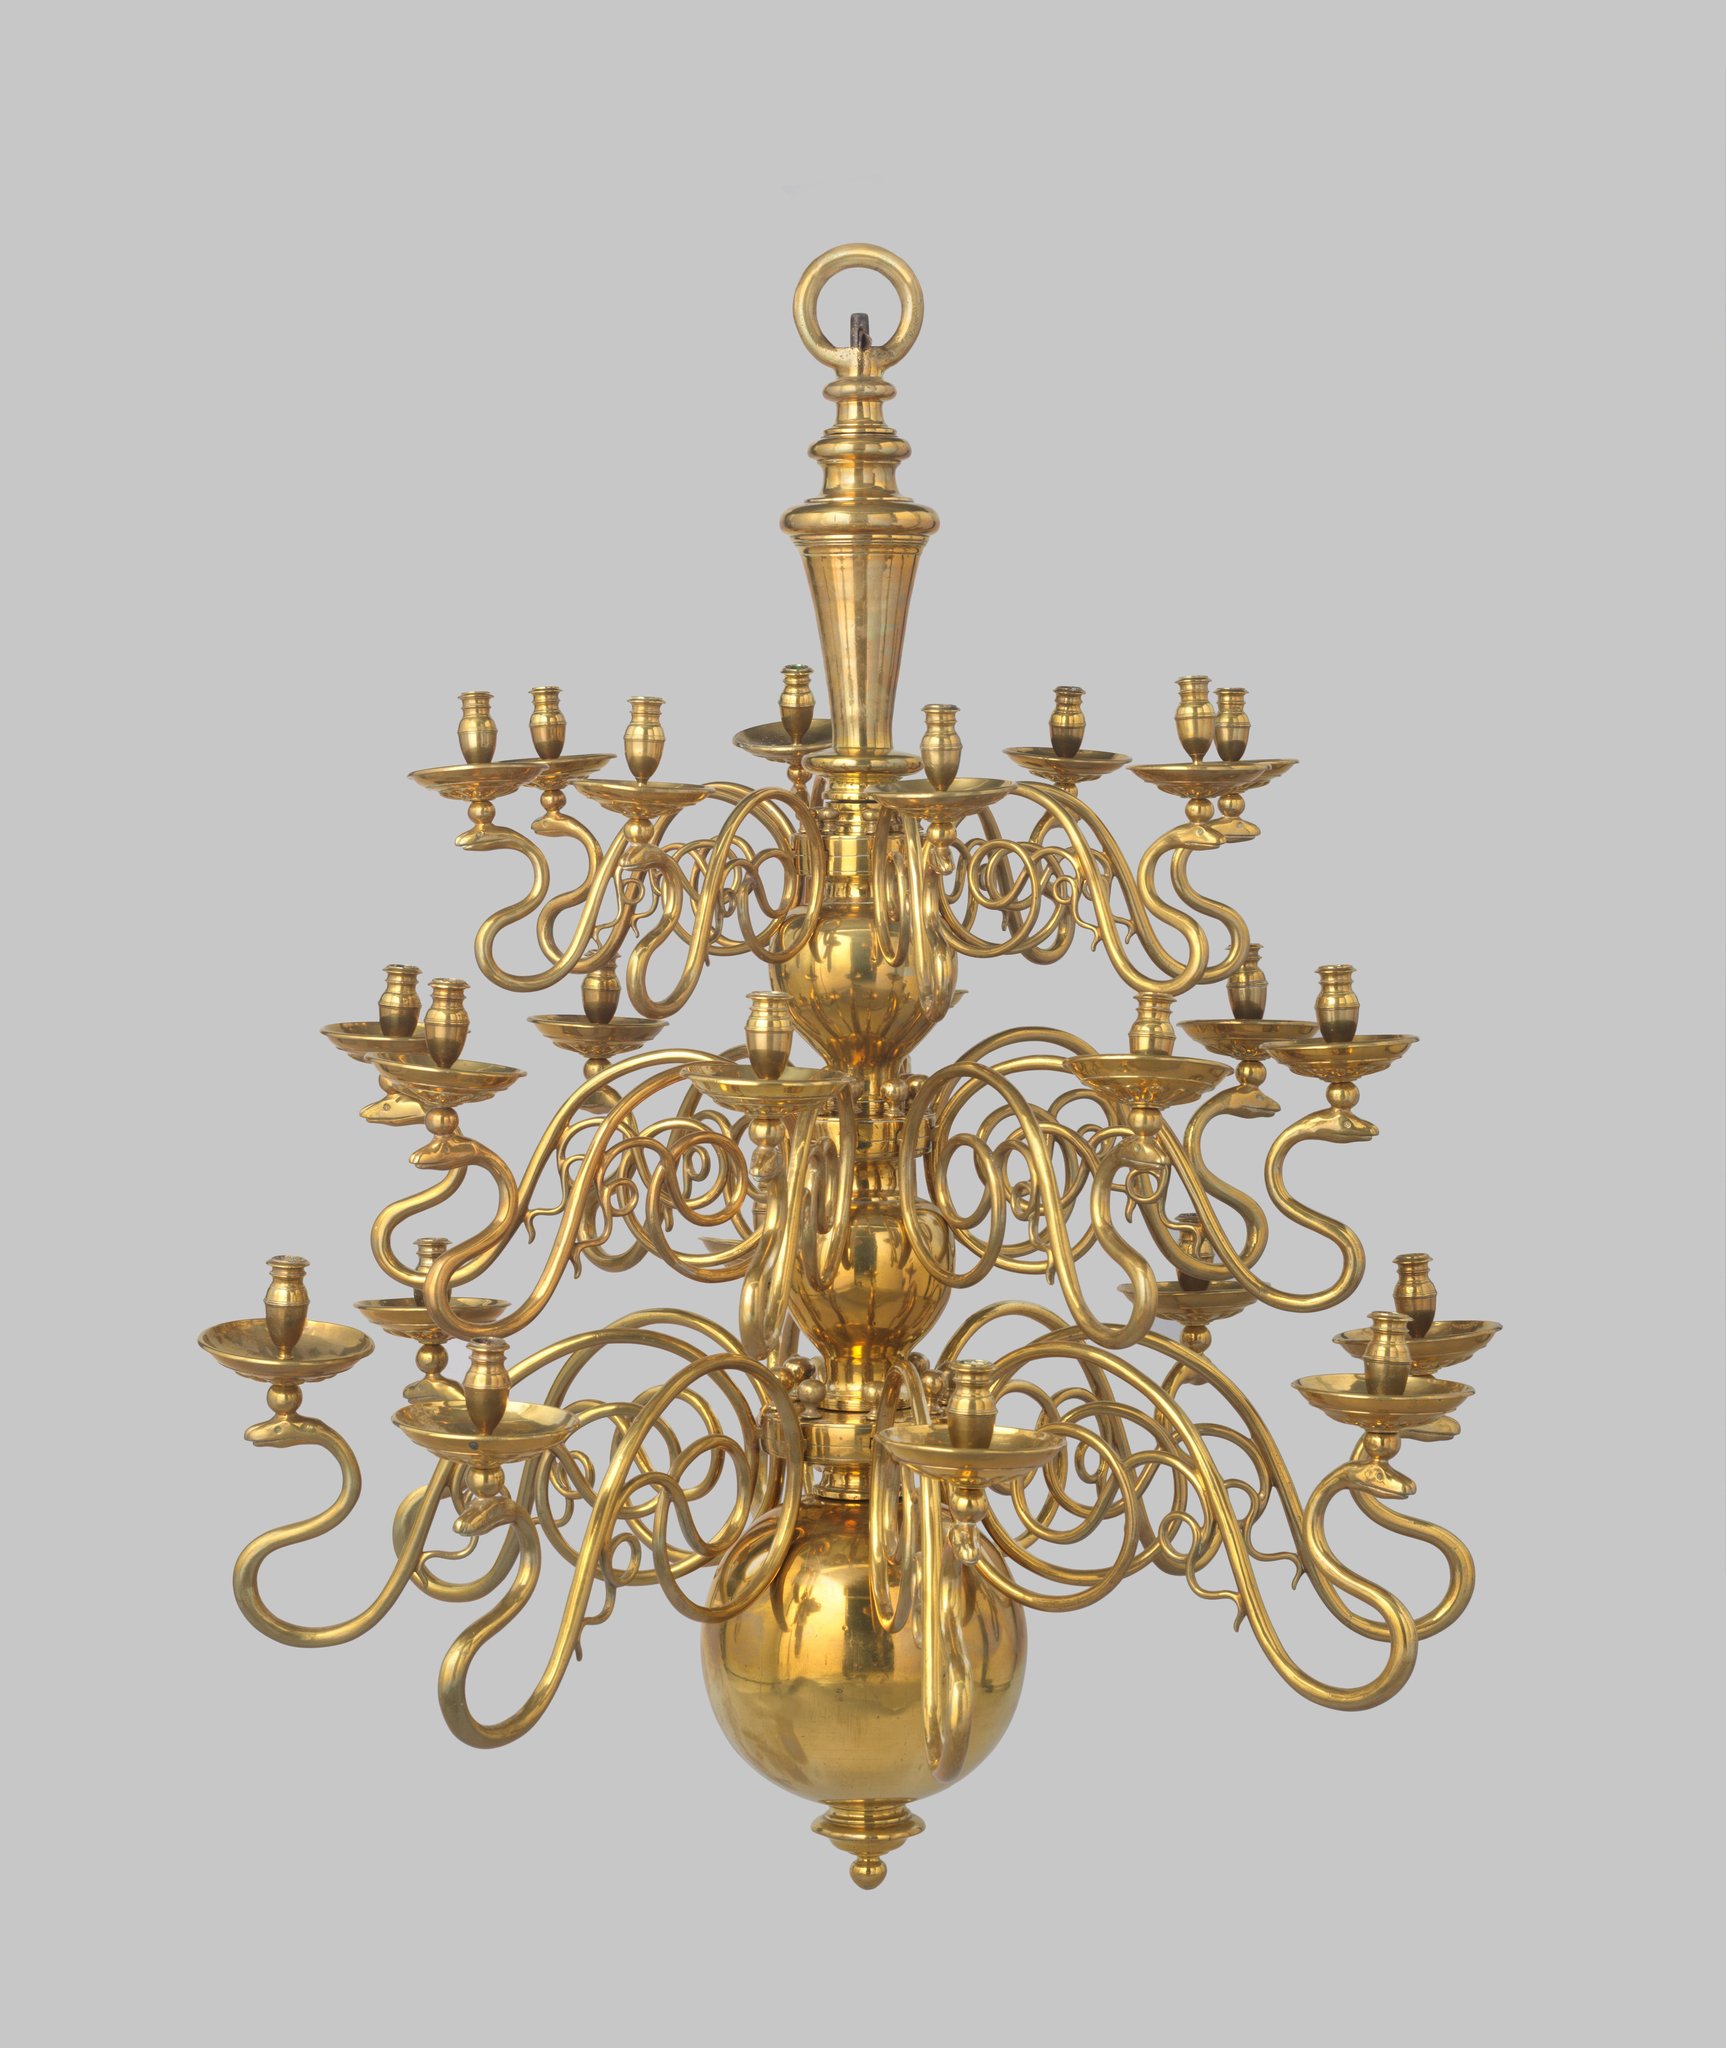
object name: chandelier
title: Arm van een kaarsenkroon in drie hoogten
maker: Anonymous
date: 1625-1650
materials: brass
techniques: screwed, turning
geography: northern netherlands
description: De arm is aan de stamzijde voorzien van een nok, waarin een gat is aangebracht om ze met een pin in de standringen te kunnen vastzetten. De S-vormige arm heeft de gedaante van een slang met een naar de stamzijde gekronkelde staart en naar buiten toe een opgeheven kop met daarop een ronde knop, waarin het van een schroefdraad voorziene gat is aangebracht ter bevestiging van de kaarsenhouders met de vetvangers. De arm is met behulp van hetzelfde model gegoten als de overige armen van de krans. De ronde kaarsenhouder is vaasvormig met een geprofileerde rib. Bovenaan heeft zij twee holronde profileringen, en een uitkragende rand en onderaan een uit twee holronde profileringen bestaande voet. De voet loopt uit in een zich verjongend schroefeind met een centergat. De bolle vetvanger is aan de bovenkant glad en heeft aan de onderkant visblaasachtige godrons en een rib. De vetvanger is met behulp van hetzelfde model gegoten als de overige vetvangers van de krans. De pinnen zijn met bolle knoppen versierd. Dit is de zesde arm van de onderste standring, genummerd op de nok met het cijfer VI.